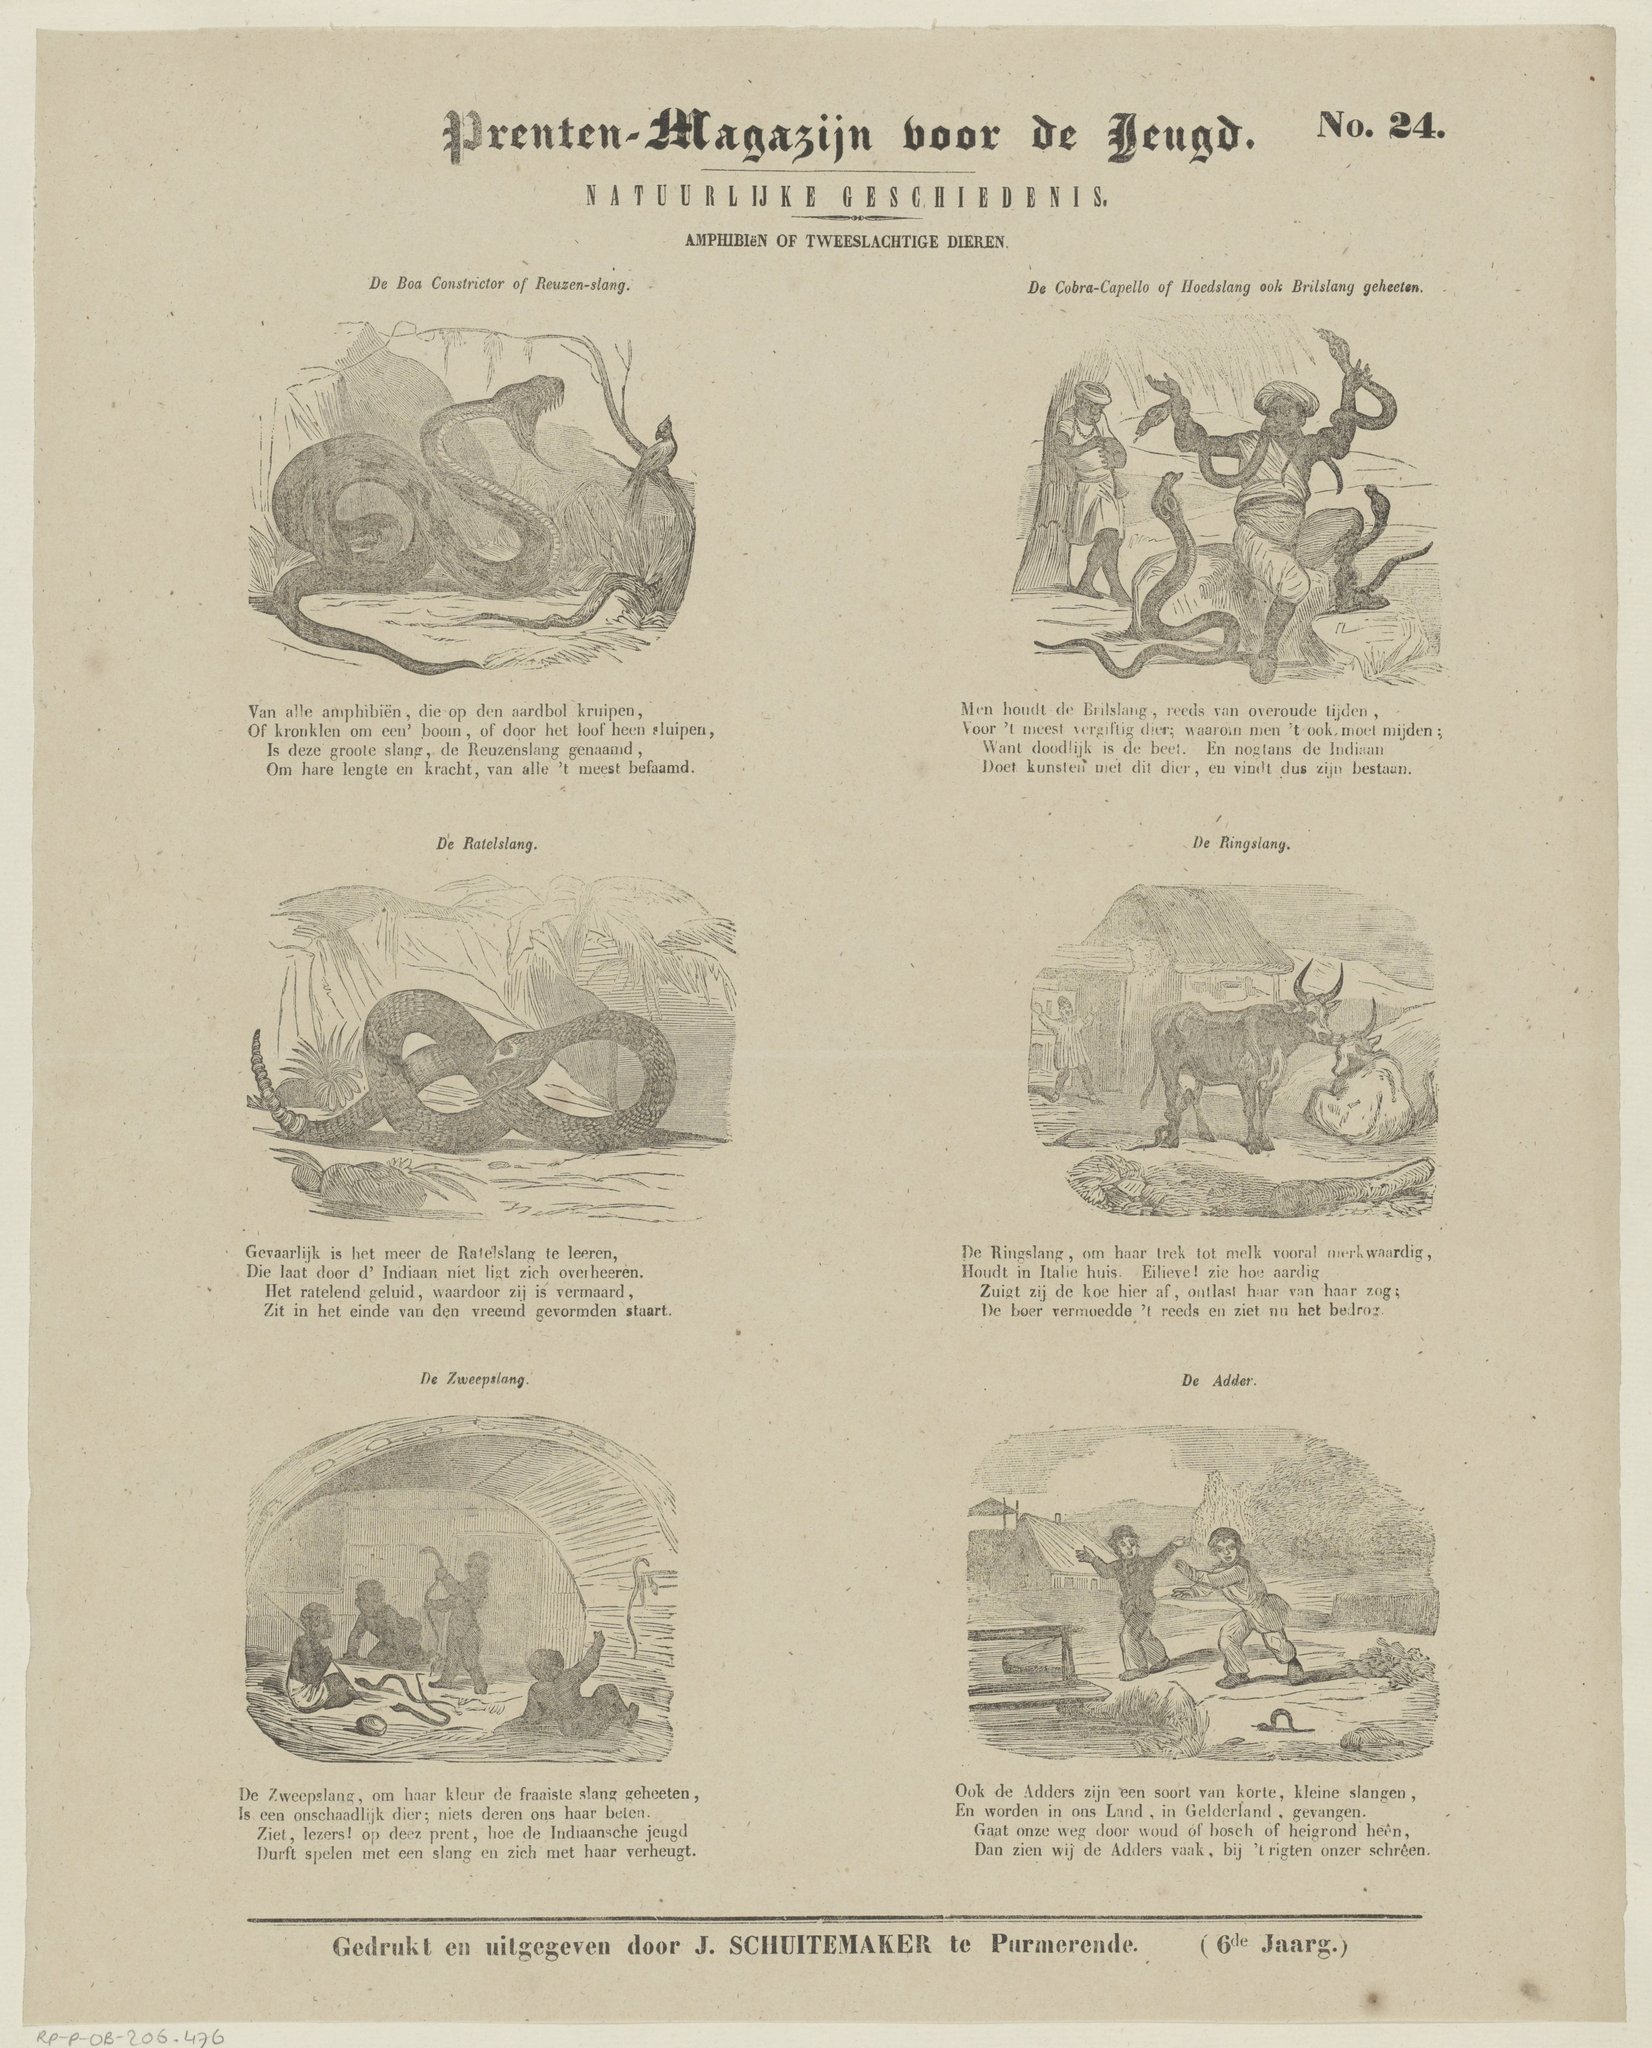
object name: print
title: Amphibiën of tweeslachtige dieren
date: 1847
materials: paper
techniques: letterpress printing, engraving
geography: netherlands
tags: snakes, amphibians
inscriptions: collector's mark: Lugt 2760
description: Blad met 6 voorstellingen van slangen. Boven elke voorstelling een titel en onder elke voorstelling een vierregelig vers. Genummerd rechtsboven: No. 24.